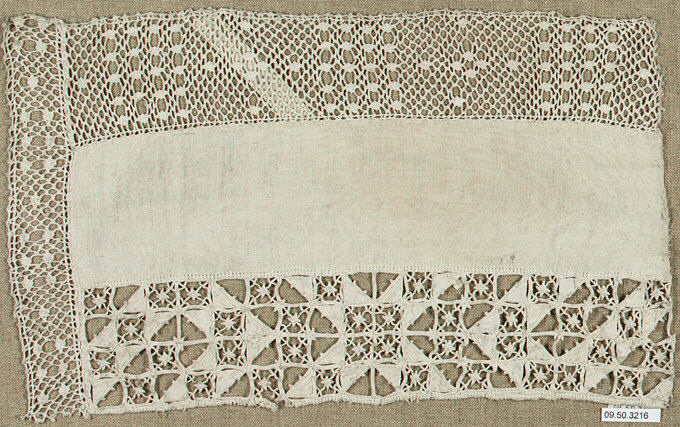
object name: fragment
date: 1601-1700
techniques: embroidery